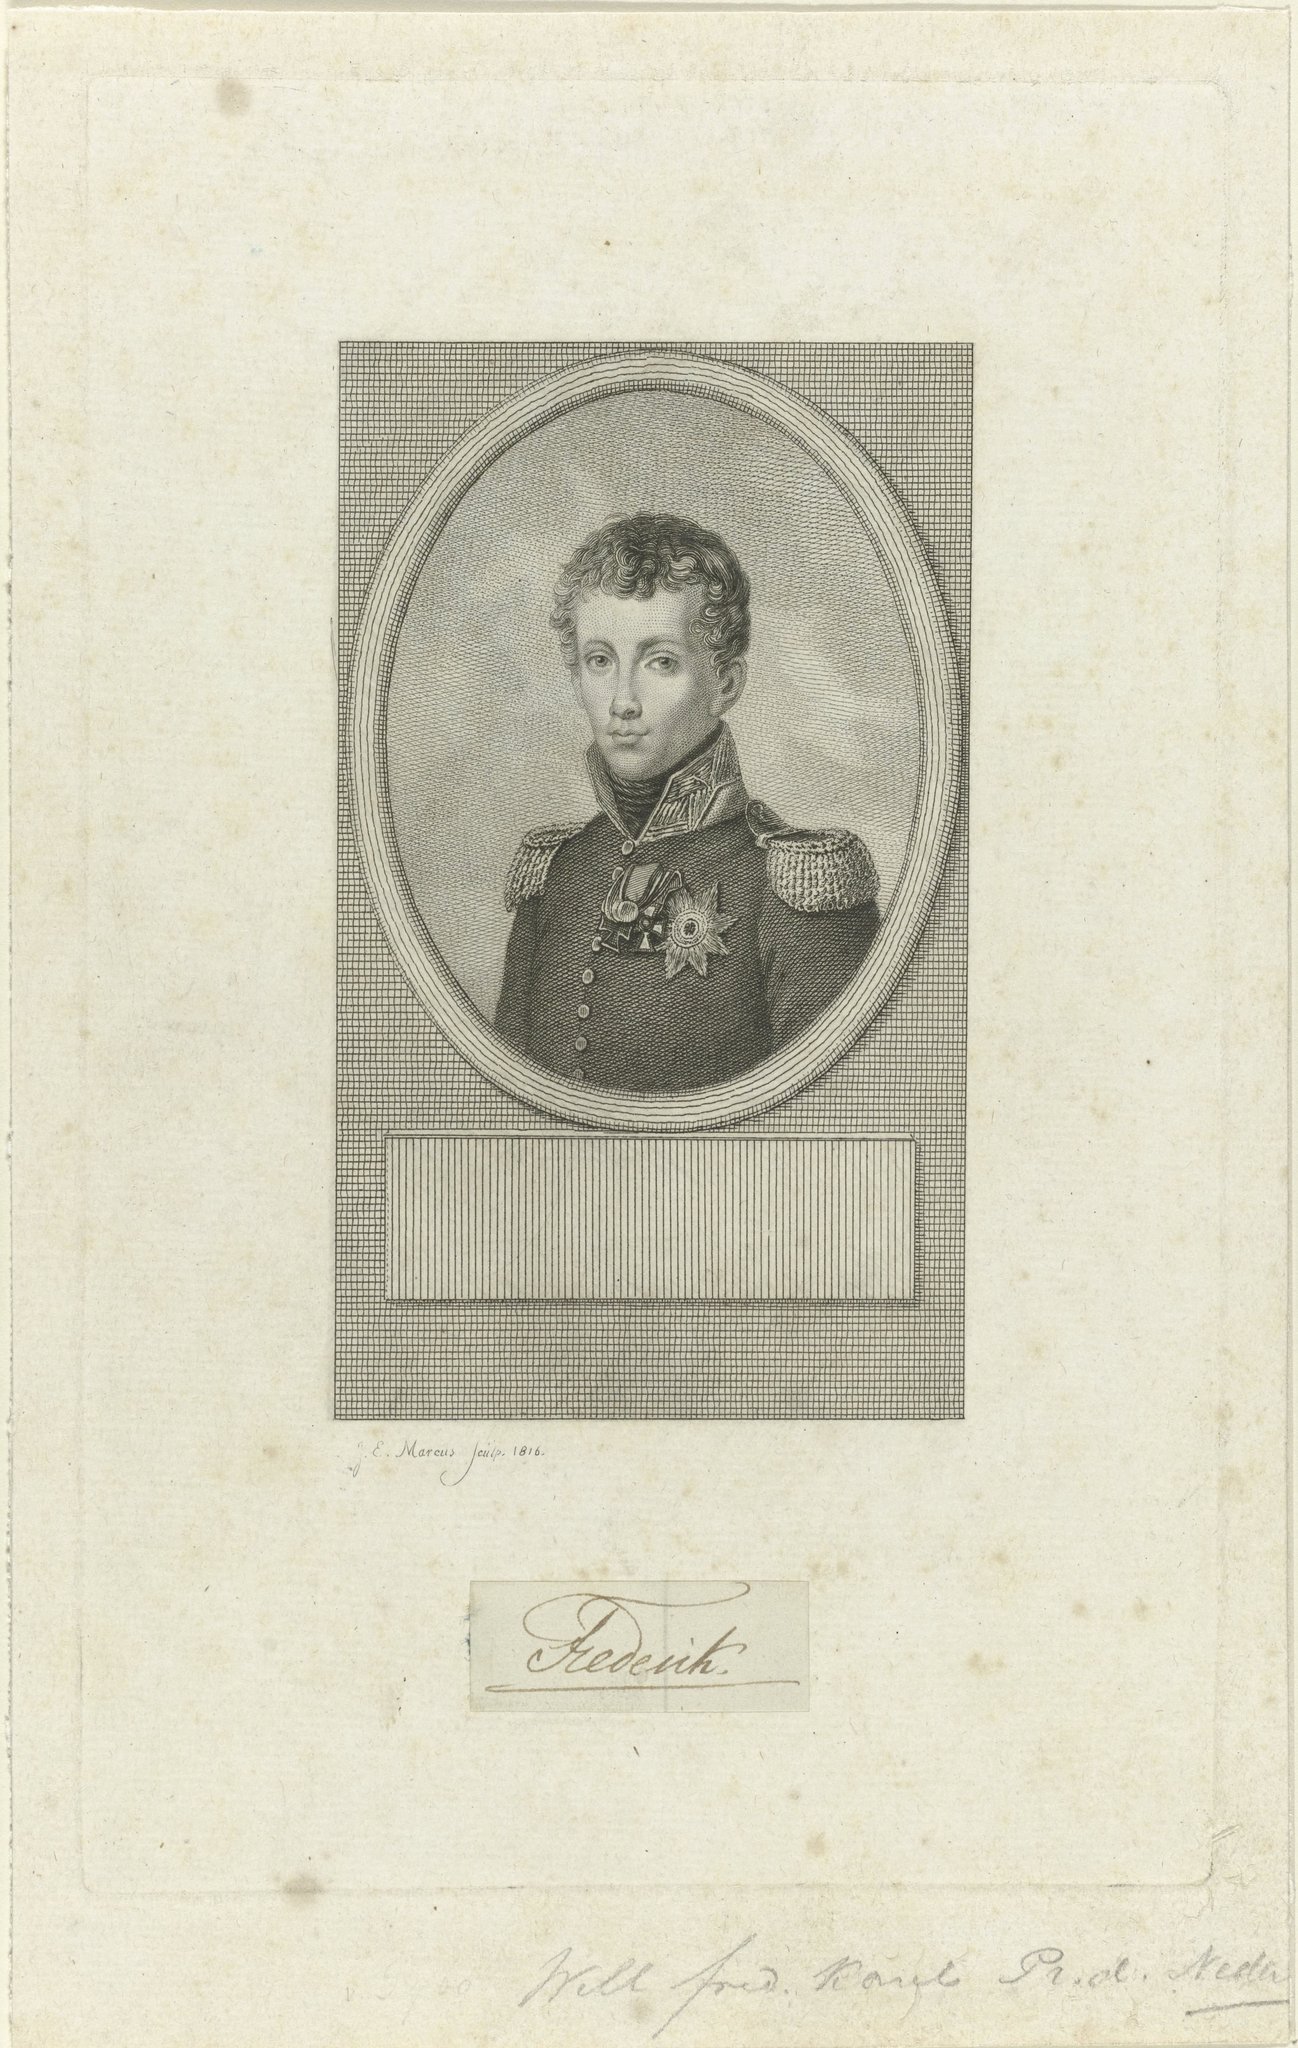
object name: print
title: Portret van Frederik, prins der Nederlanden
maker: jacob ernst marcus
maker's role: draughtsman, print maker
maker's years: 1774-1826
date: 1816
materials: paper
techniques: engraving, etching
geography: amsterdam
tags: berlin, frederik (prins der nederlanden), knighthood order (with name) - insignia of a knighthood order, e.g.: badge, chain (with name of order)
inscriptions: date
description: De hier vermelde titel verwijst naar de hoogst verkregen titel van de geportretteerde, niet per se naar de titel die de geportretteerde op deze voorstelling draagt.